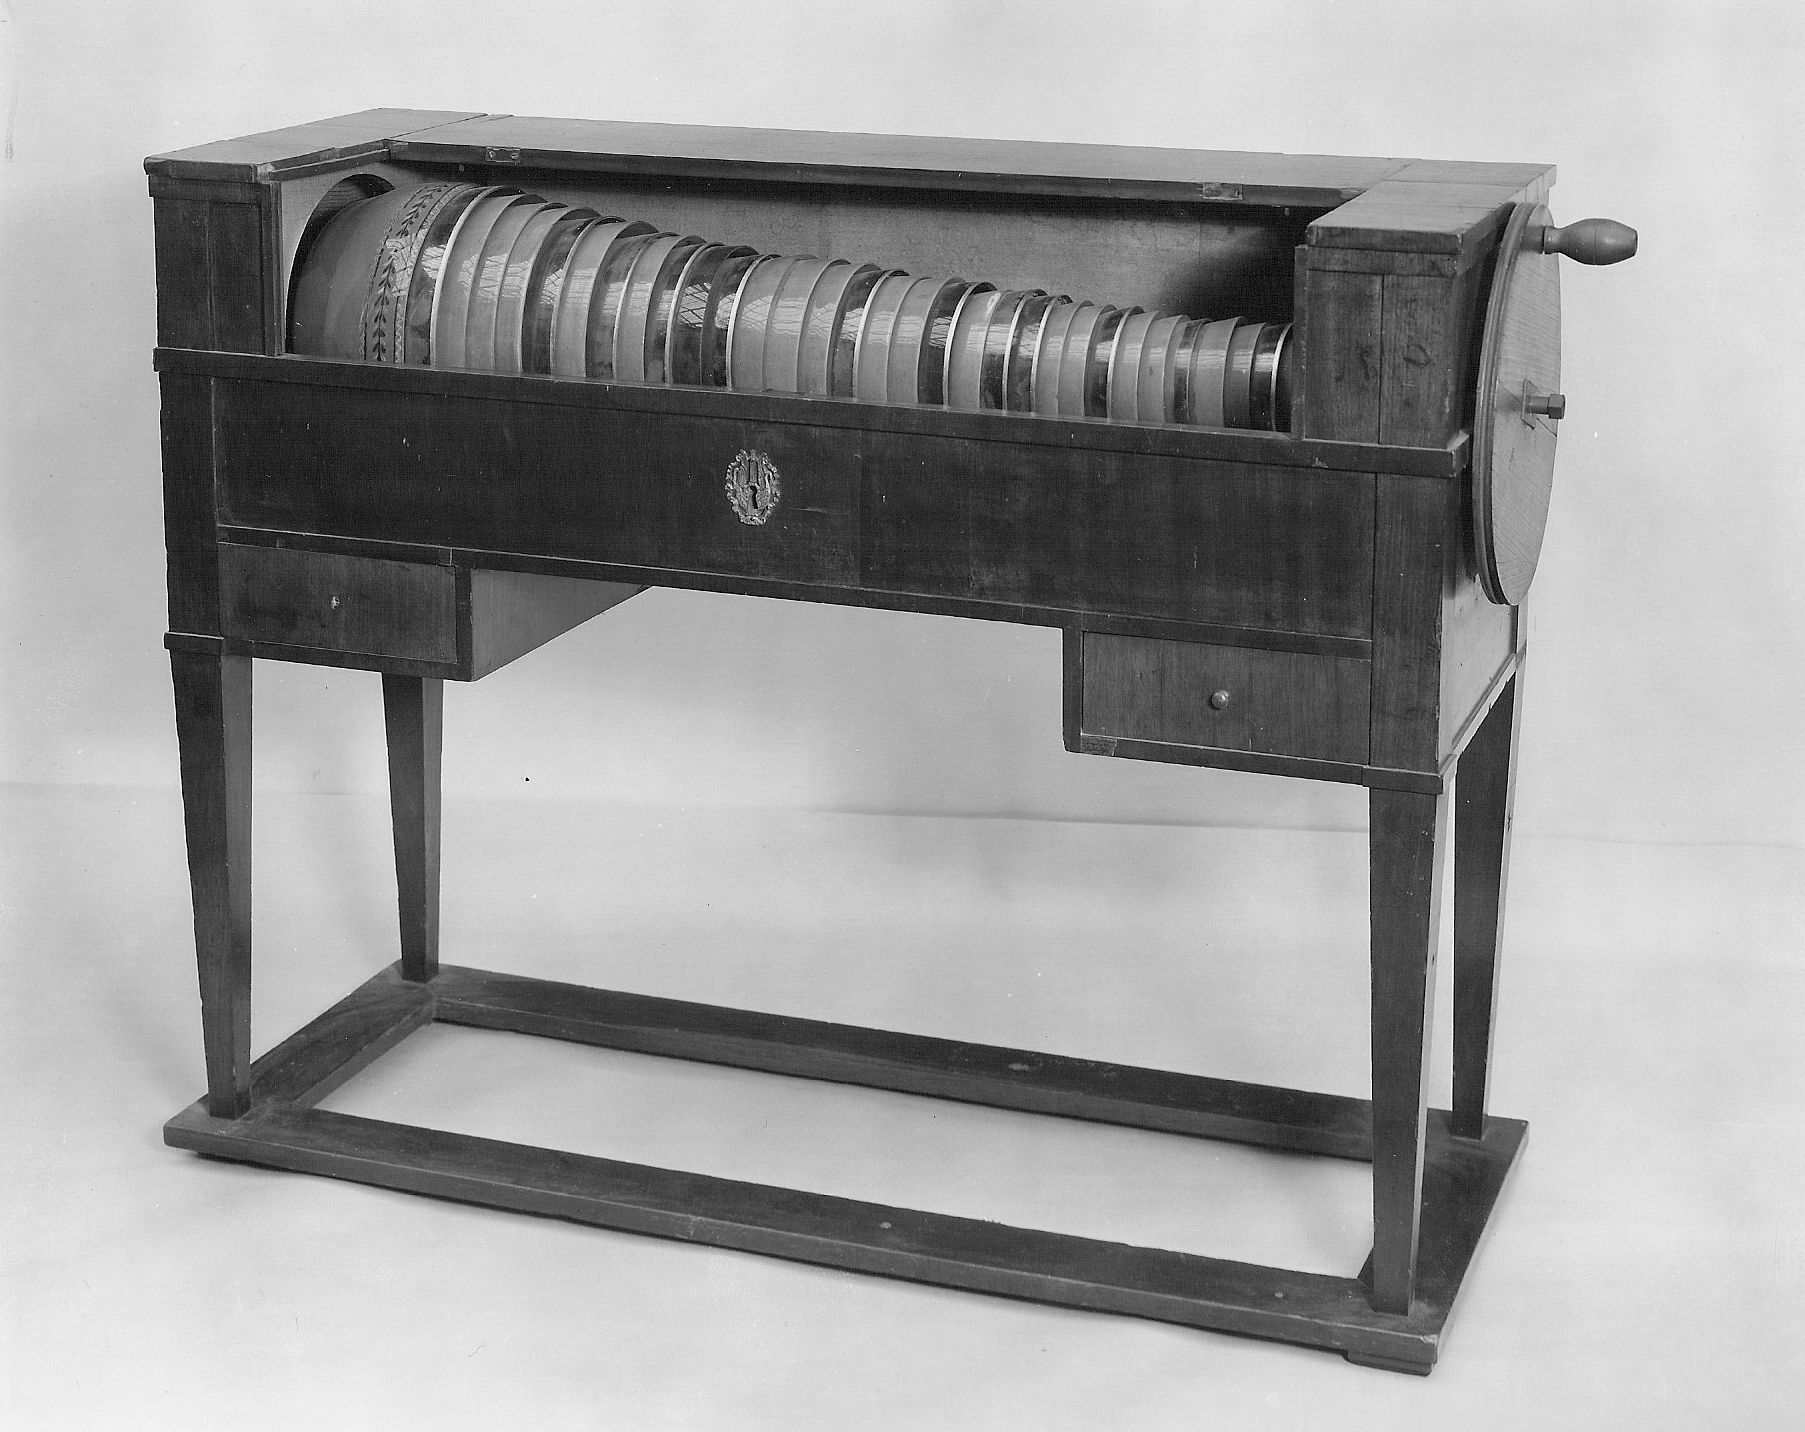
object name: glass harmonica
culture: german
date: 1701-1800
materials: glass, wood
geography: germany